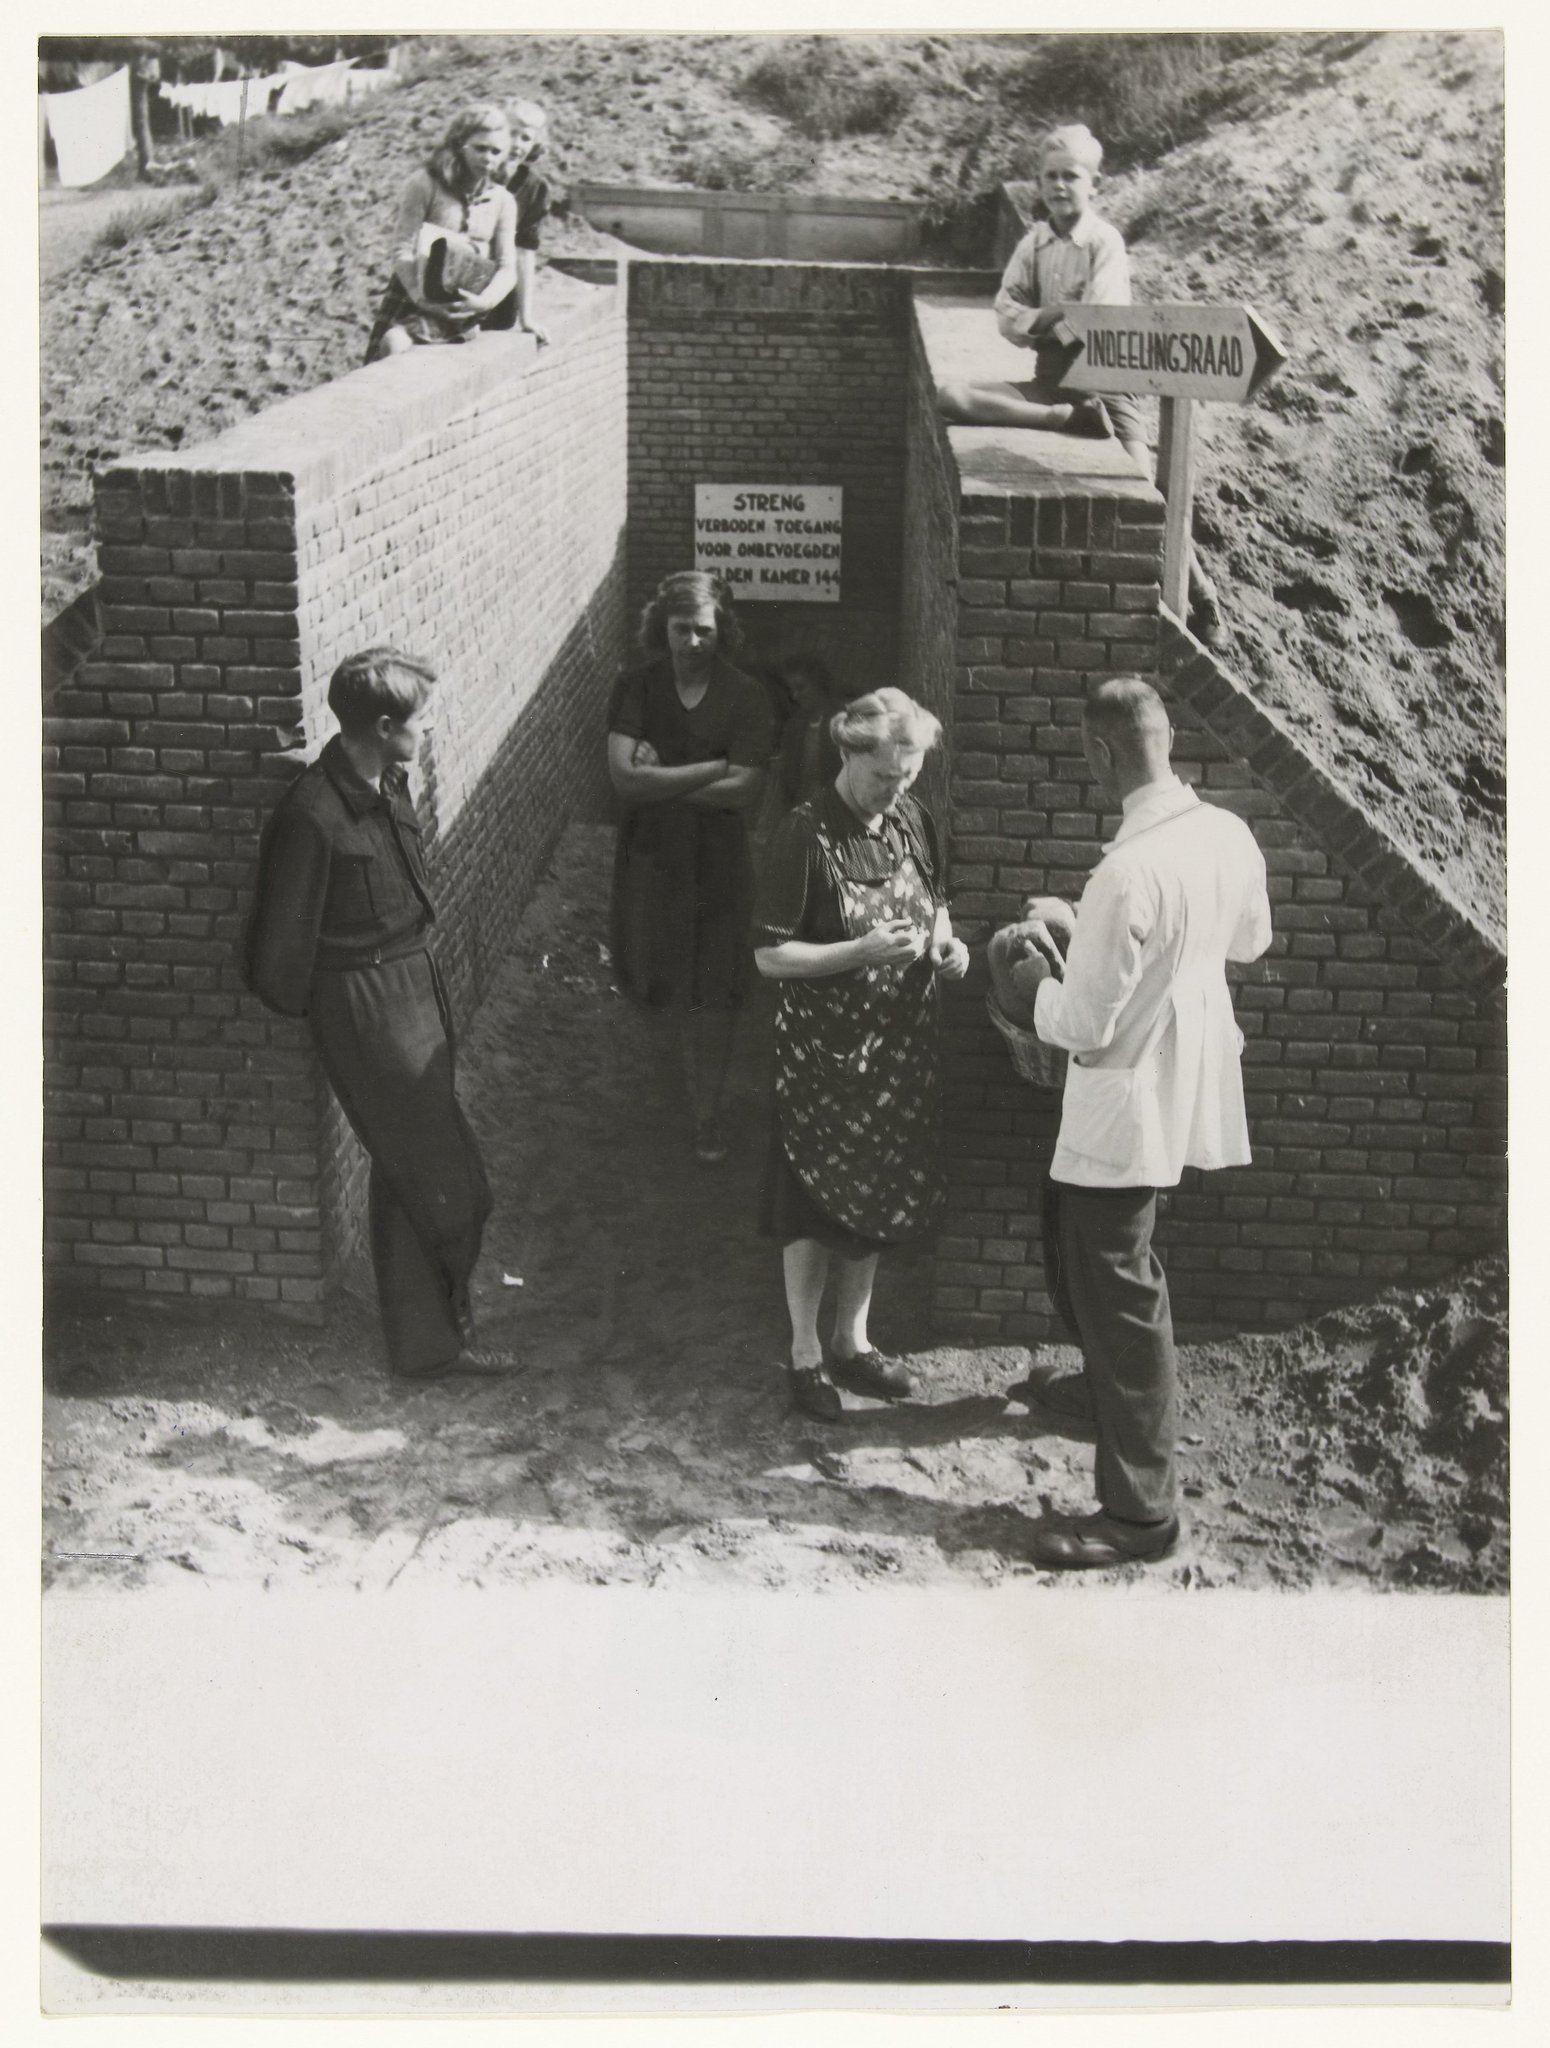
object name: documentary photograph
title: Mannen, vrouwen en kinderen bij de ingang van een schuilkelder in Nijmegen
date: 1911-1946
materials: photographic support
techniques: photography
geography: nijmegen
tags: nijmegen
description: Een vrouw in gesprek met een broodventer voor de ingang van een schuilkelder gadegeslagen door een man en vrouw die net de kelder verlaten met op de achtergrond een aantal kinderen. In 1946 leefden in deze schuilkelder nog steeds ongeveer 200 mensen.